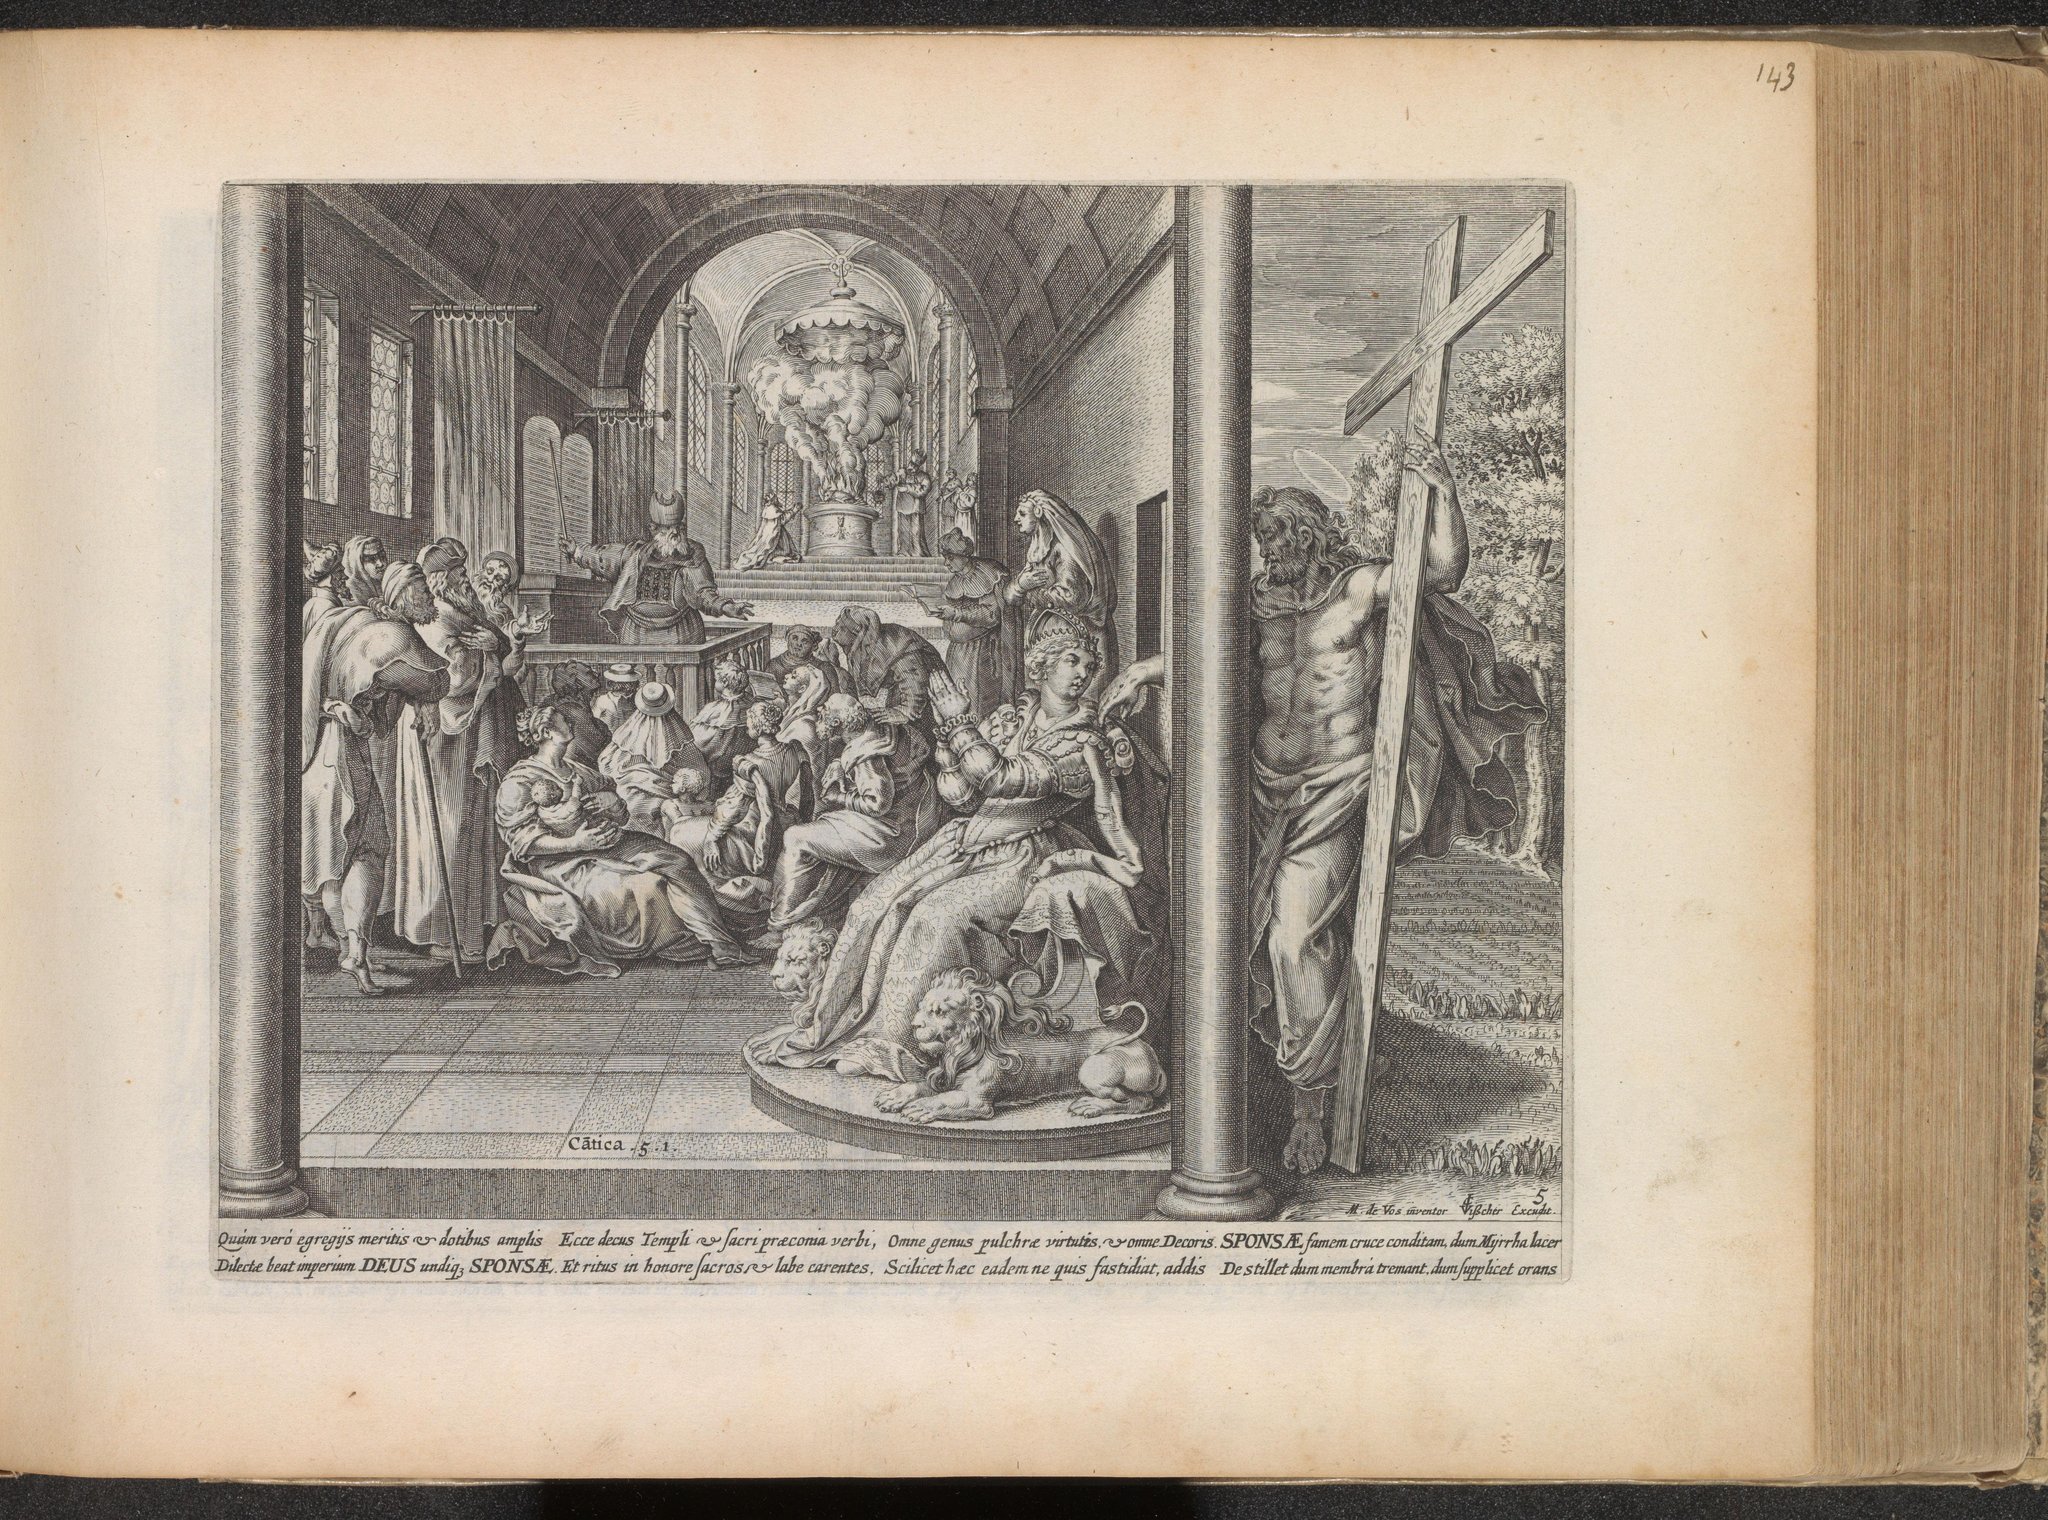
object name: album leaf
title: Canticum Canticorum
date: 1643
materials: paper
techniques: engraving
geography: amsterdam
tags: 'ecclesia' as bride of christ (the lamb), 'ecclesia sponsa dei', 'sponsus-sponsa', tabernacle, temple, synagogue, and other sanctuaries ~ jewish religion, song of solomon, song of songs (with book chapter:verse) (+ christ bearded)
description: De bruid van Christus (de kerk) zit op een troon in een tempel. Christus staat met zijn kruis buiten in een tuin en door een raam raakt zijn hand haar schouder. Op de achtergrond kijken toeschouwers naar een hogepriester die over de tafelen der wet preekt en wordt er een lam op een altaar geofferd. Onder de voorstelling een verwijzing in het Latijn naar de Bijbeltekst in Hoogl. 5:1. Deze prent maakt deel uit van een album.